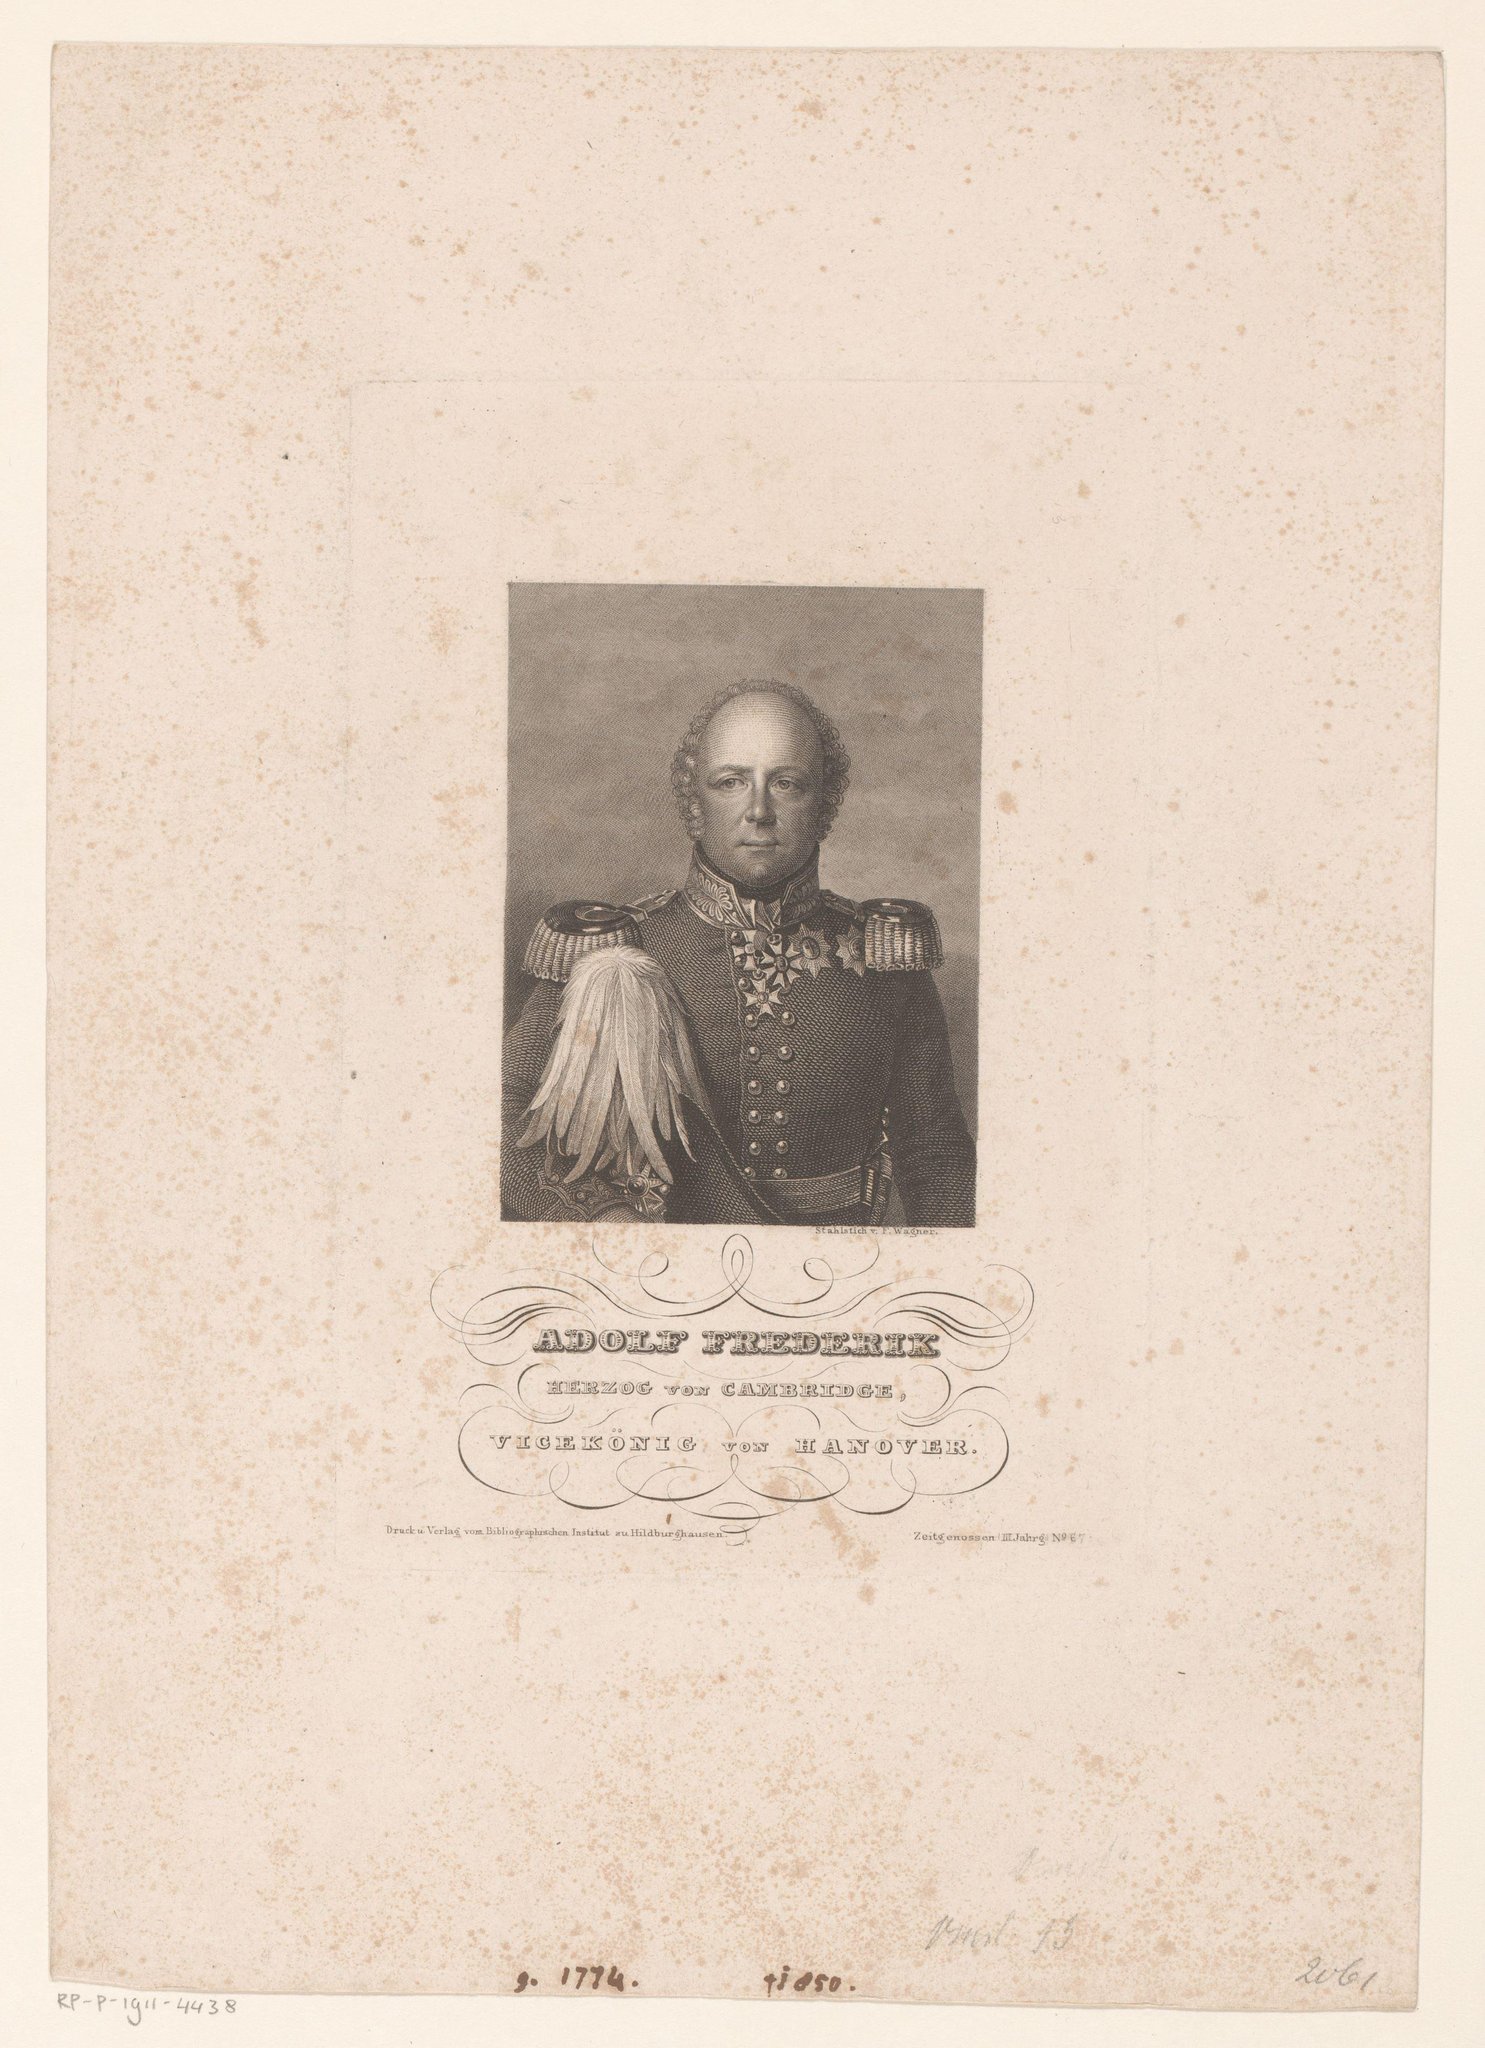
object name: print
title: Portret van Adolf Frederik, hertog van Cambridge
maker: friedrich wagner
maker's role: painter, print maker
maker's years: 1801-1850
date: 1828-1840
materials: paper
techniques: engraving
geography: hildburghausen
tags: london, historical persons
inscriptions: collector's mark: Lugt 2228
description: Rechtsonder: Zeitgenossen (III Jahrg:) No 67.